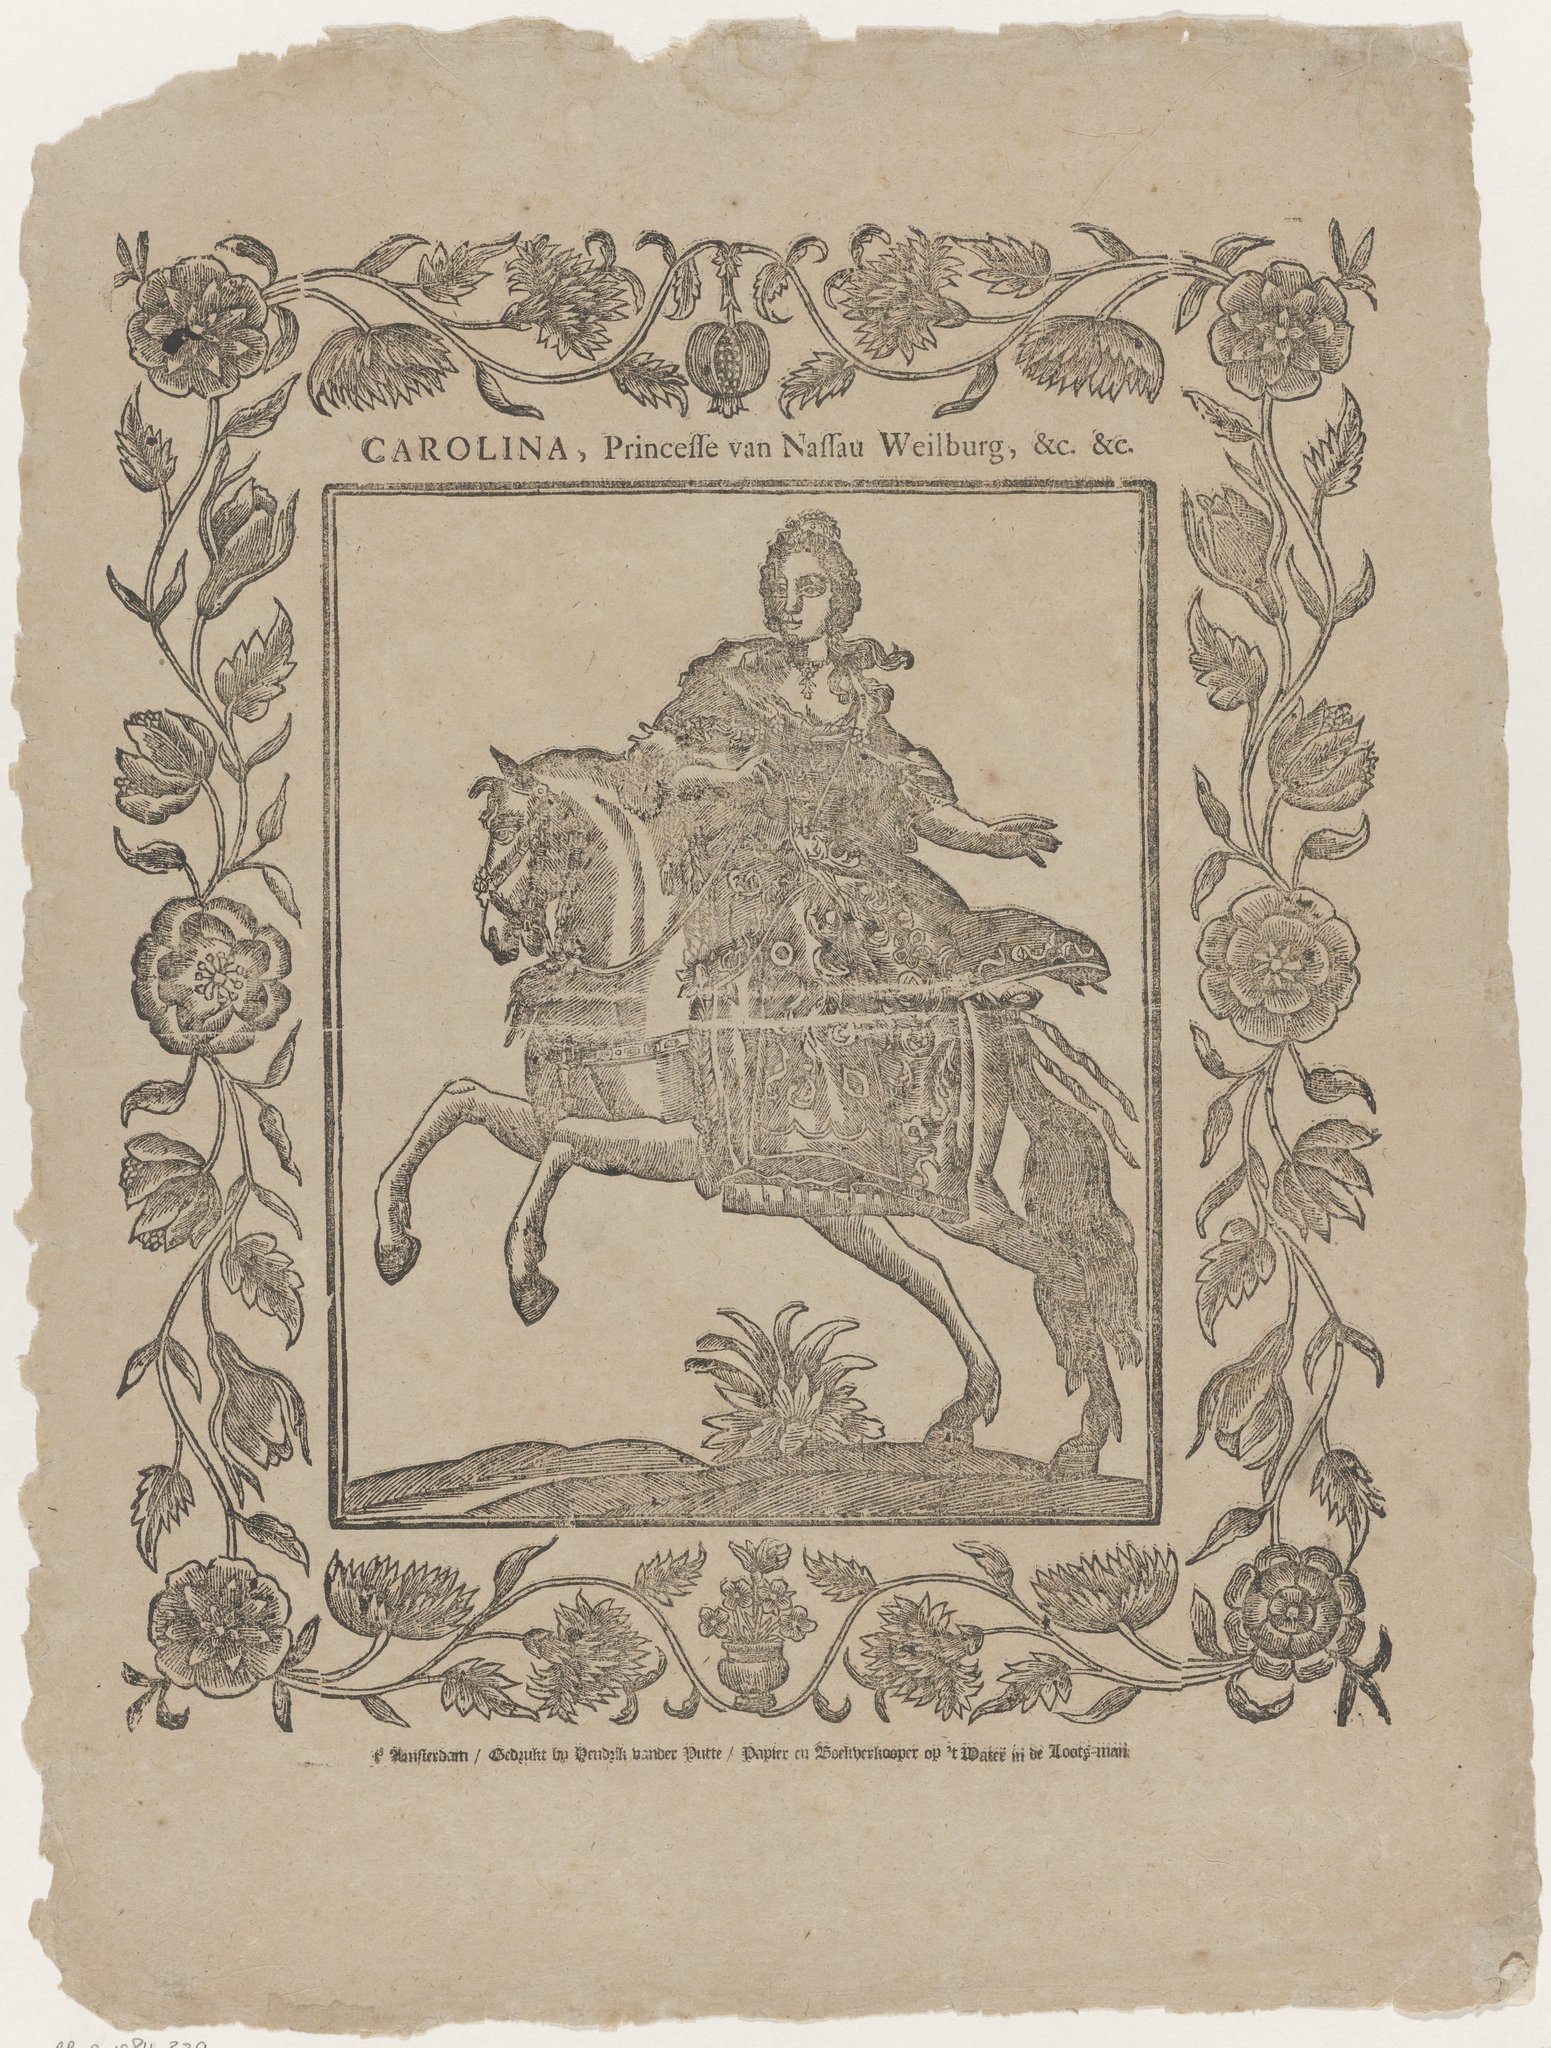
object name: popular print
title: Carolina, Princesse van Nassau Weilburg, &c. &c.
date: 1761-1765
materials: paper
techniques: letterpress printing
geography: netherlands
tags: carolina (prinses van oranje-nassau), equestrian state-portrait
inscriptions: collector's mark: Lugt 2760, collector's mark: Lugt 2228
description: Ruiterportret van Carolina (prinses van Oranje-Nassau). De voorstelling is gevat in een sierlijst van bloemenranken.